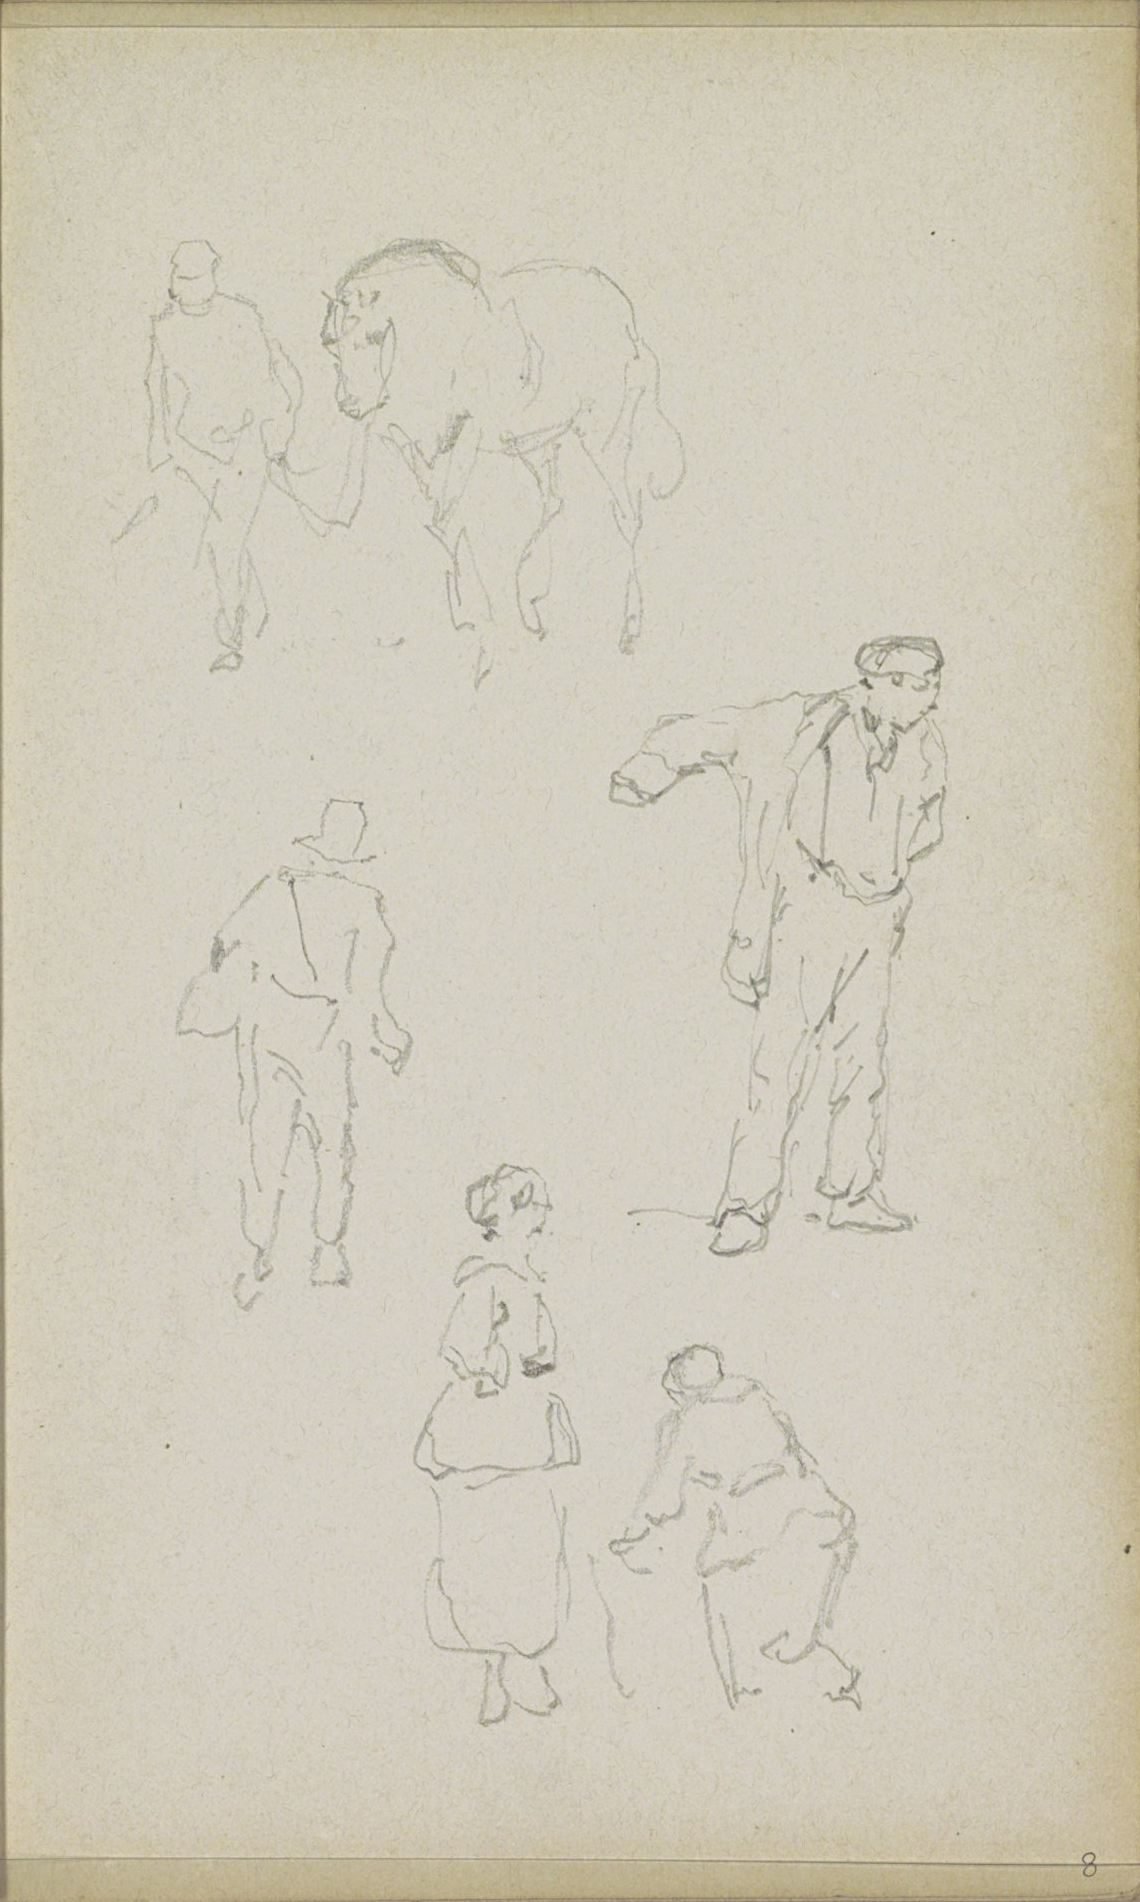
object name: sketchbook leaf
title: Figuurstudies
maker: adrianus eversen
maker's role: draughtsman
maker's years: 1818-1897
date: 1828-1897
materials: paper, pencil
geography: netherlands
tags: adult woman, adult man, horse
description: Boven een man met een paard aan het leidsel. Links een man, op de rug gezien met een zak over zijn schouder. Rechts een man die zijn jas aan- of uittrekt. Onder twee vrouwen, van wie één mogelijk de was doet. Blad 8 recto uit een schetsboek met 69 bladen vervaardigd in de omgeving van Delft, Rotterdam, Oudewater en Harlingen.